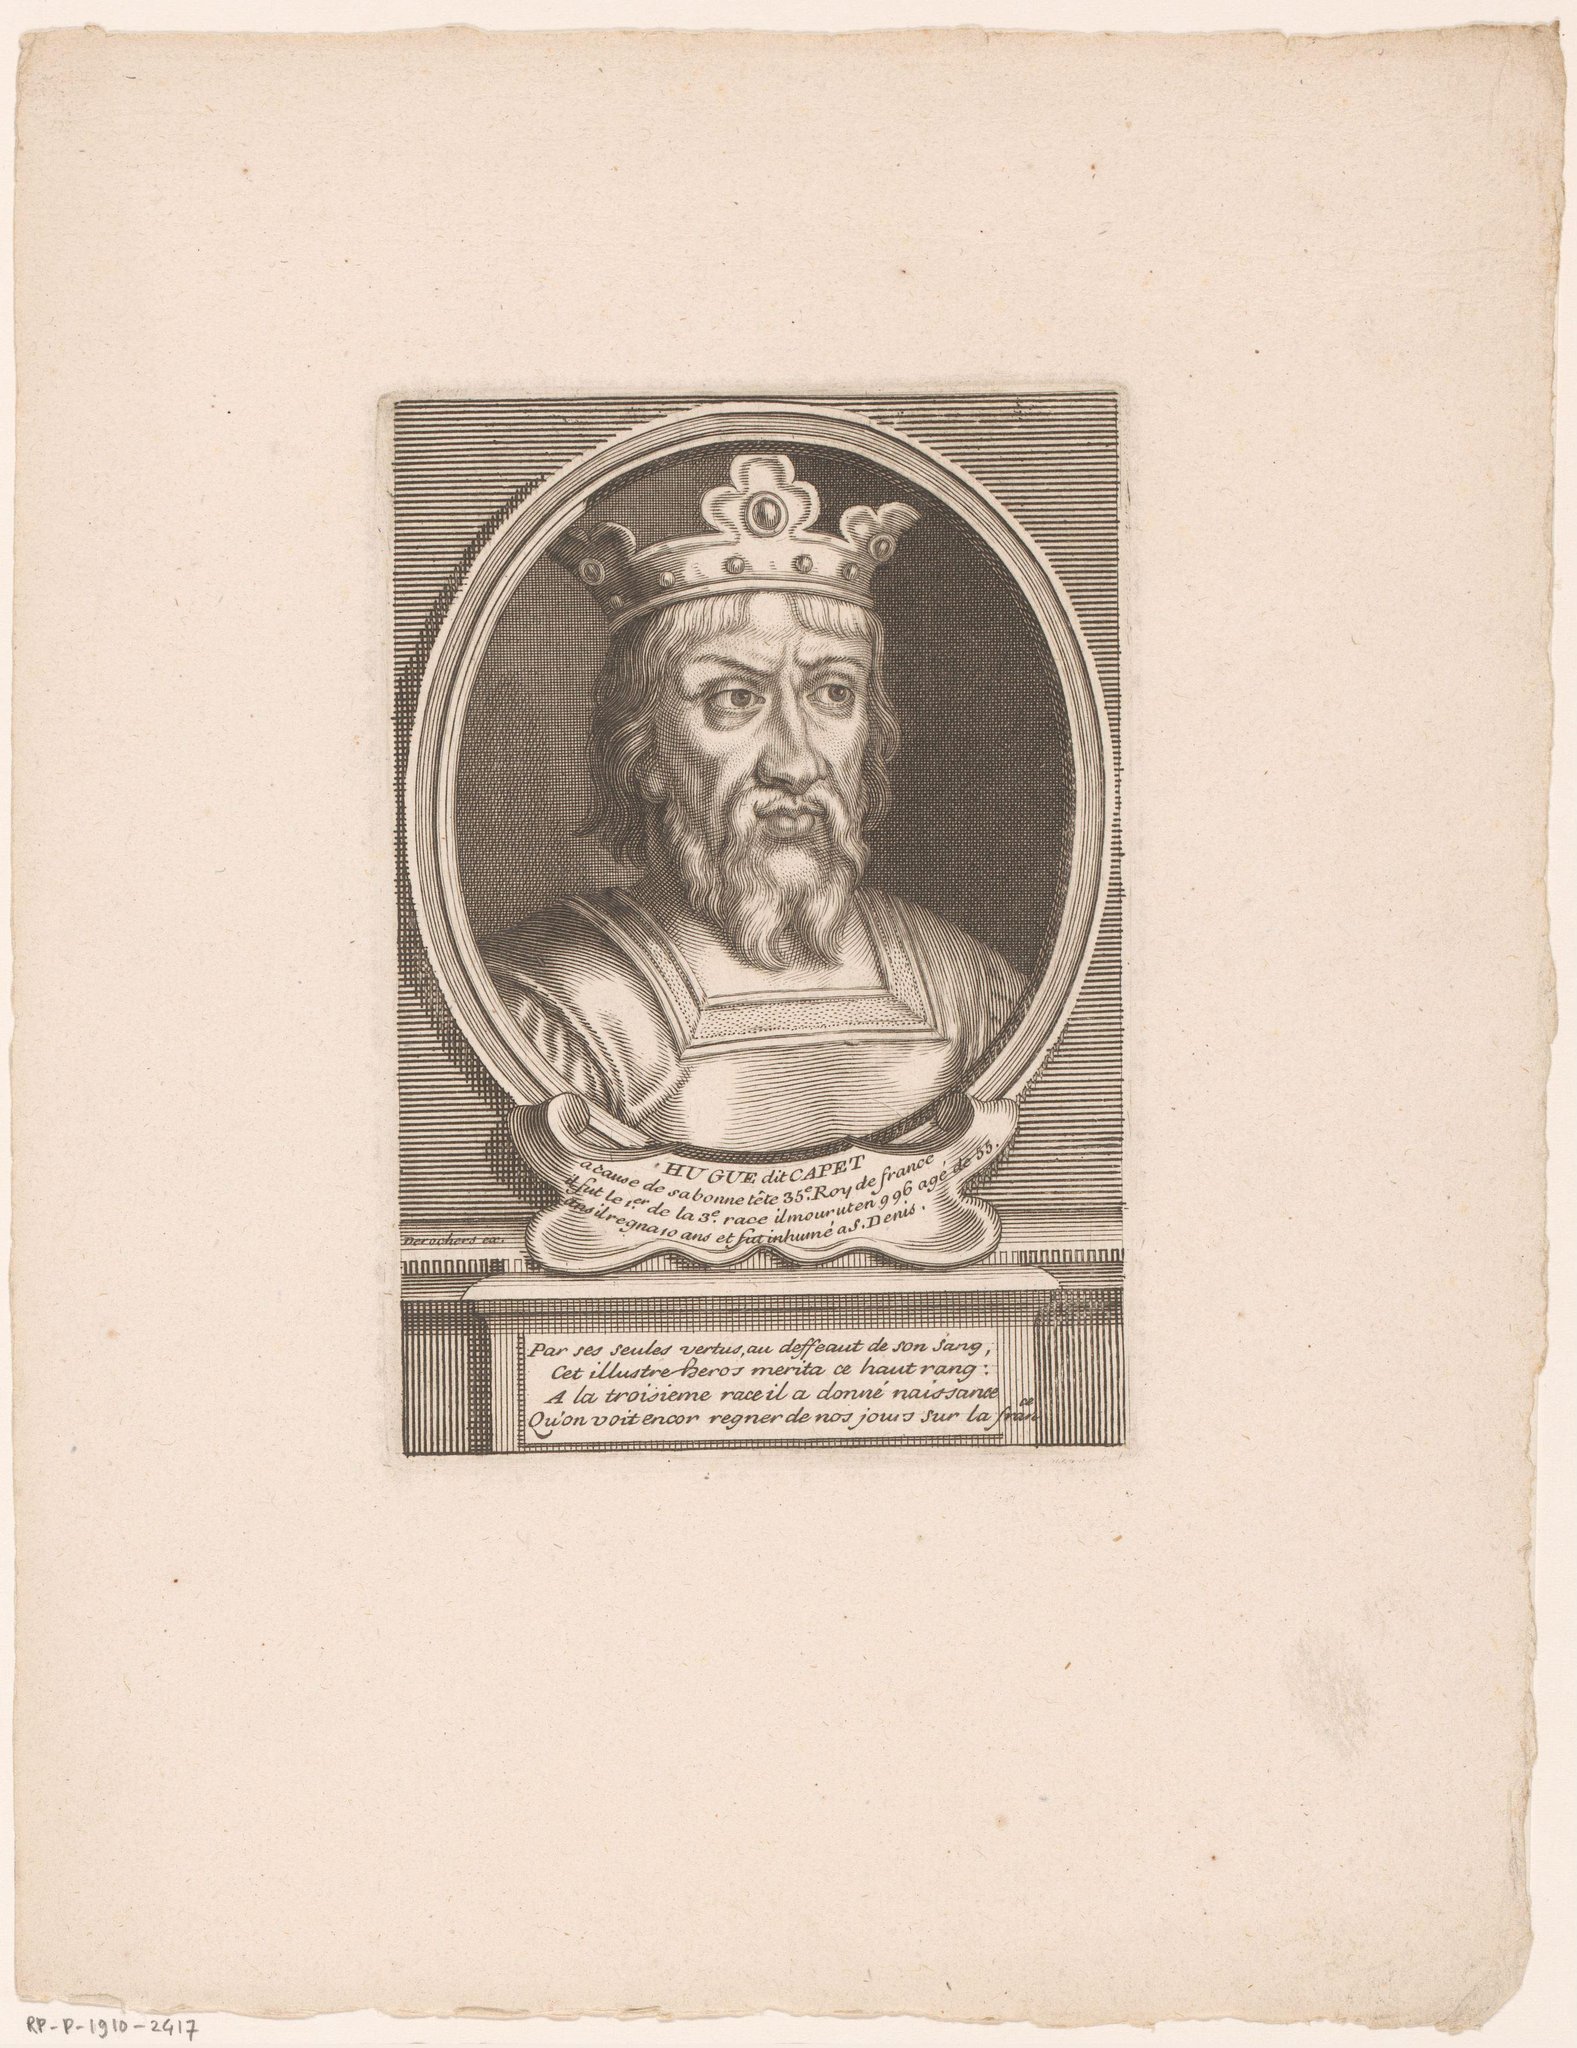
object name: print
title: Portret van Hugo Capet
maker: étienne desrochers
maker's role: print maker, publisher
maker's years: 1668-1741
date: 1726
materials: paper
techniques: engraving, etching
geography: paris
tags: historical persons, king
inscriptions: collector's mark: Lugt 2228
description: Behoort waarschijnlijk tot een serie portretten, grotendeels door Etienne Desrochers, getiteld: 'Recueil de portraits de personnes qui se sont distinguées tant dans les Armes que dans Belles-Lettres et les Arts, comme aussi la famille royale de France et autres cours étrangères'. De serie werd initieel uitgegeven door Desrochers en aangekondigd in 'Mercure' in mei 1726, p. 985. Echter was Desrochers reeds enkele jaren eerder begonnen met het uitgeven van de serie. Na de dood van Desrochers werd de serie voortgezet door Gilles Edme Petit. Een latere staat werd uitgegeven door Jean François Daumont in Parijs.